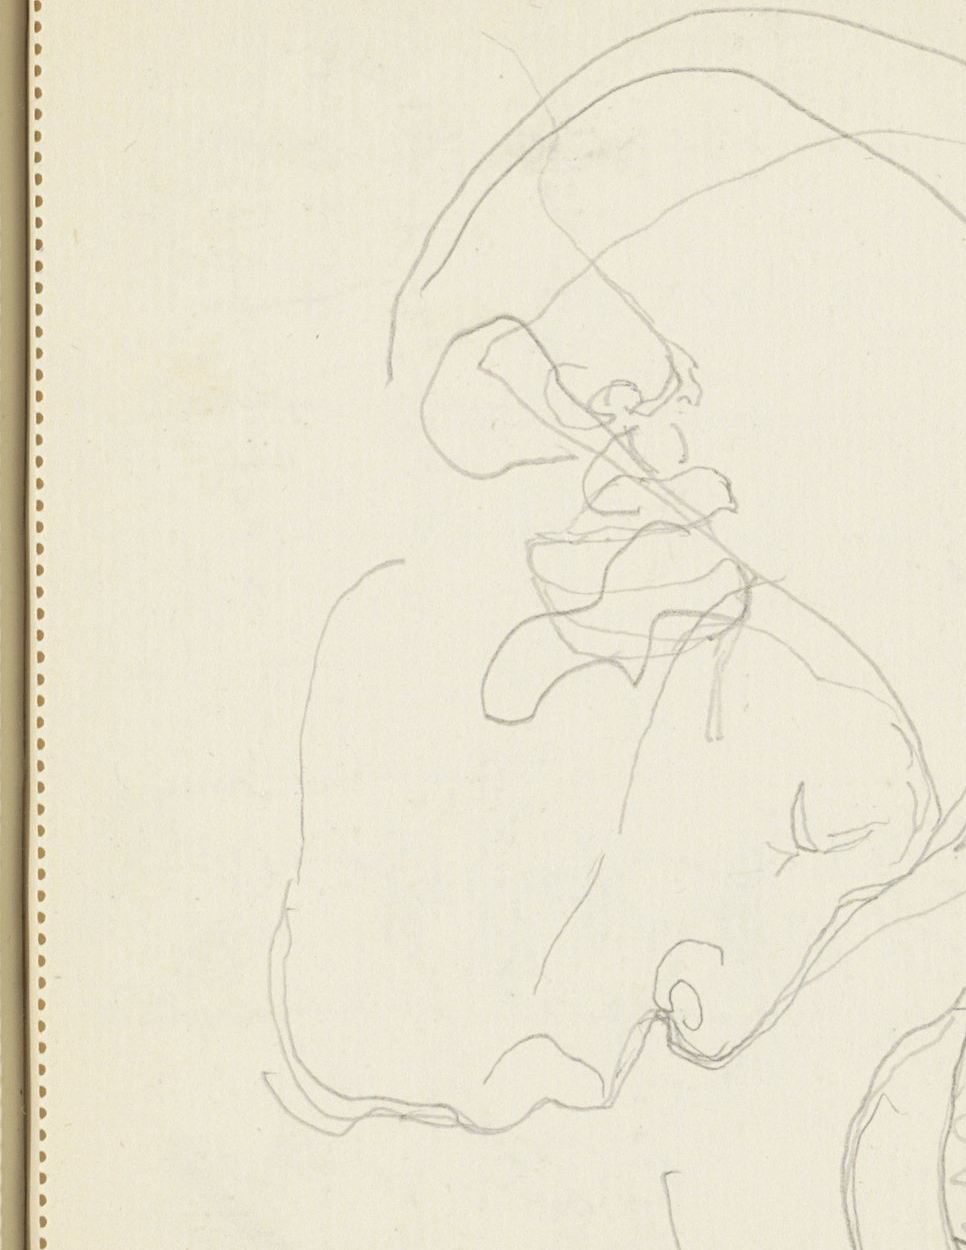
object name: sketchbook leaf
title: Afrikaanse vrouw met een hoofddeksel met bloem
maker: reijer stolk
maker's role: draughtsman, print maker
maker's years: 1896-1945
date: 1916-1945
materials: paper, pencil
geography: africa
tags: africans, mouth, head (human) - aa - female human figure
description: Tevens een studie van een mond. Blad 46 recto uit een schetsboek met 60 bladen.